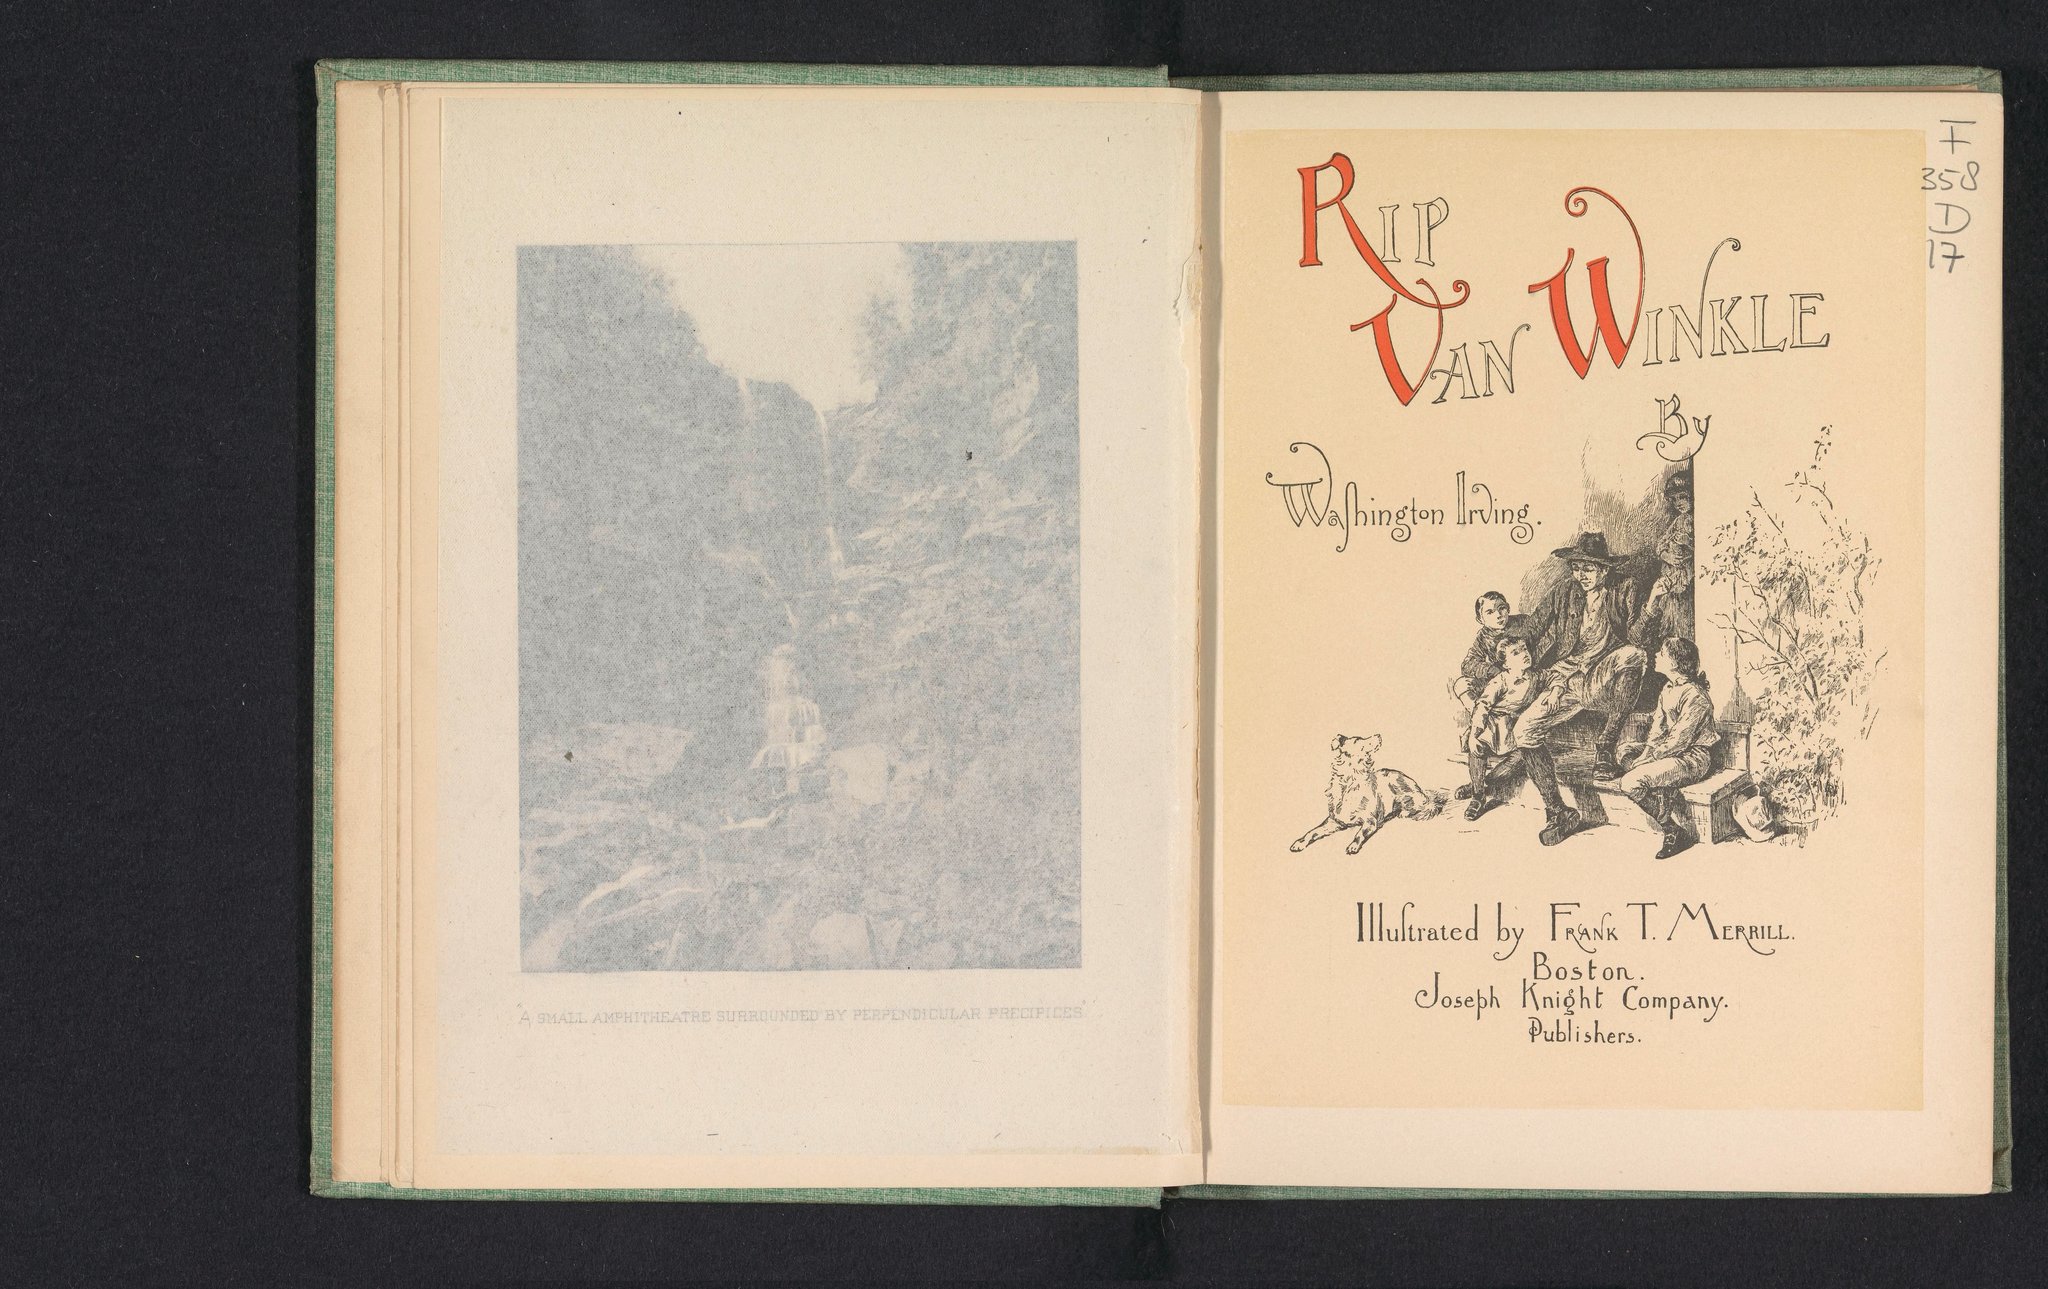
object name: book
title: Rip van Winkle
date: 1894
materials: cardboard, linen, paper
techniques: photoaquatint, printing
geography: boston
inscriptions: name: ‘Janet D. [...[ravill from Mary Arnold Petrie’